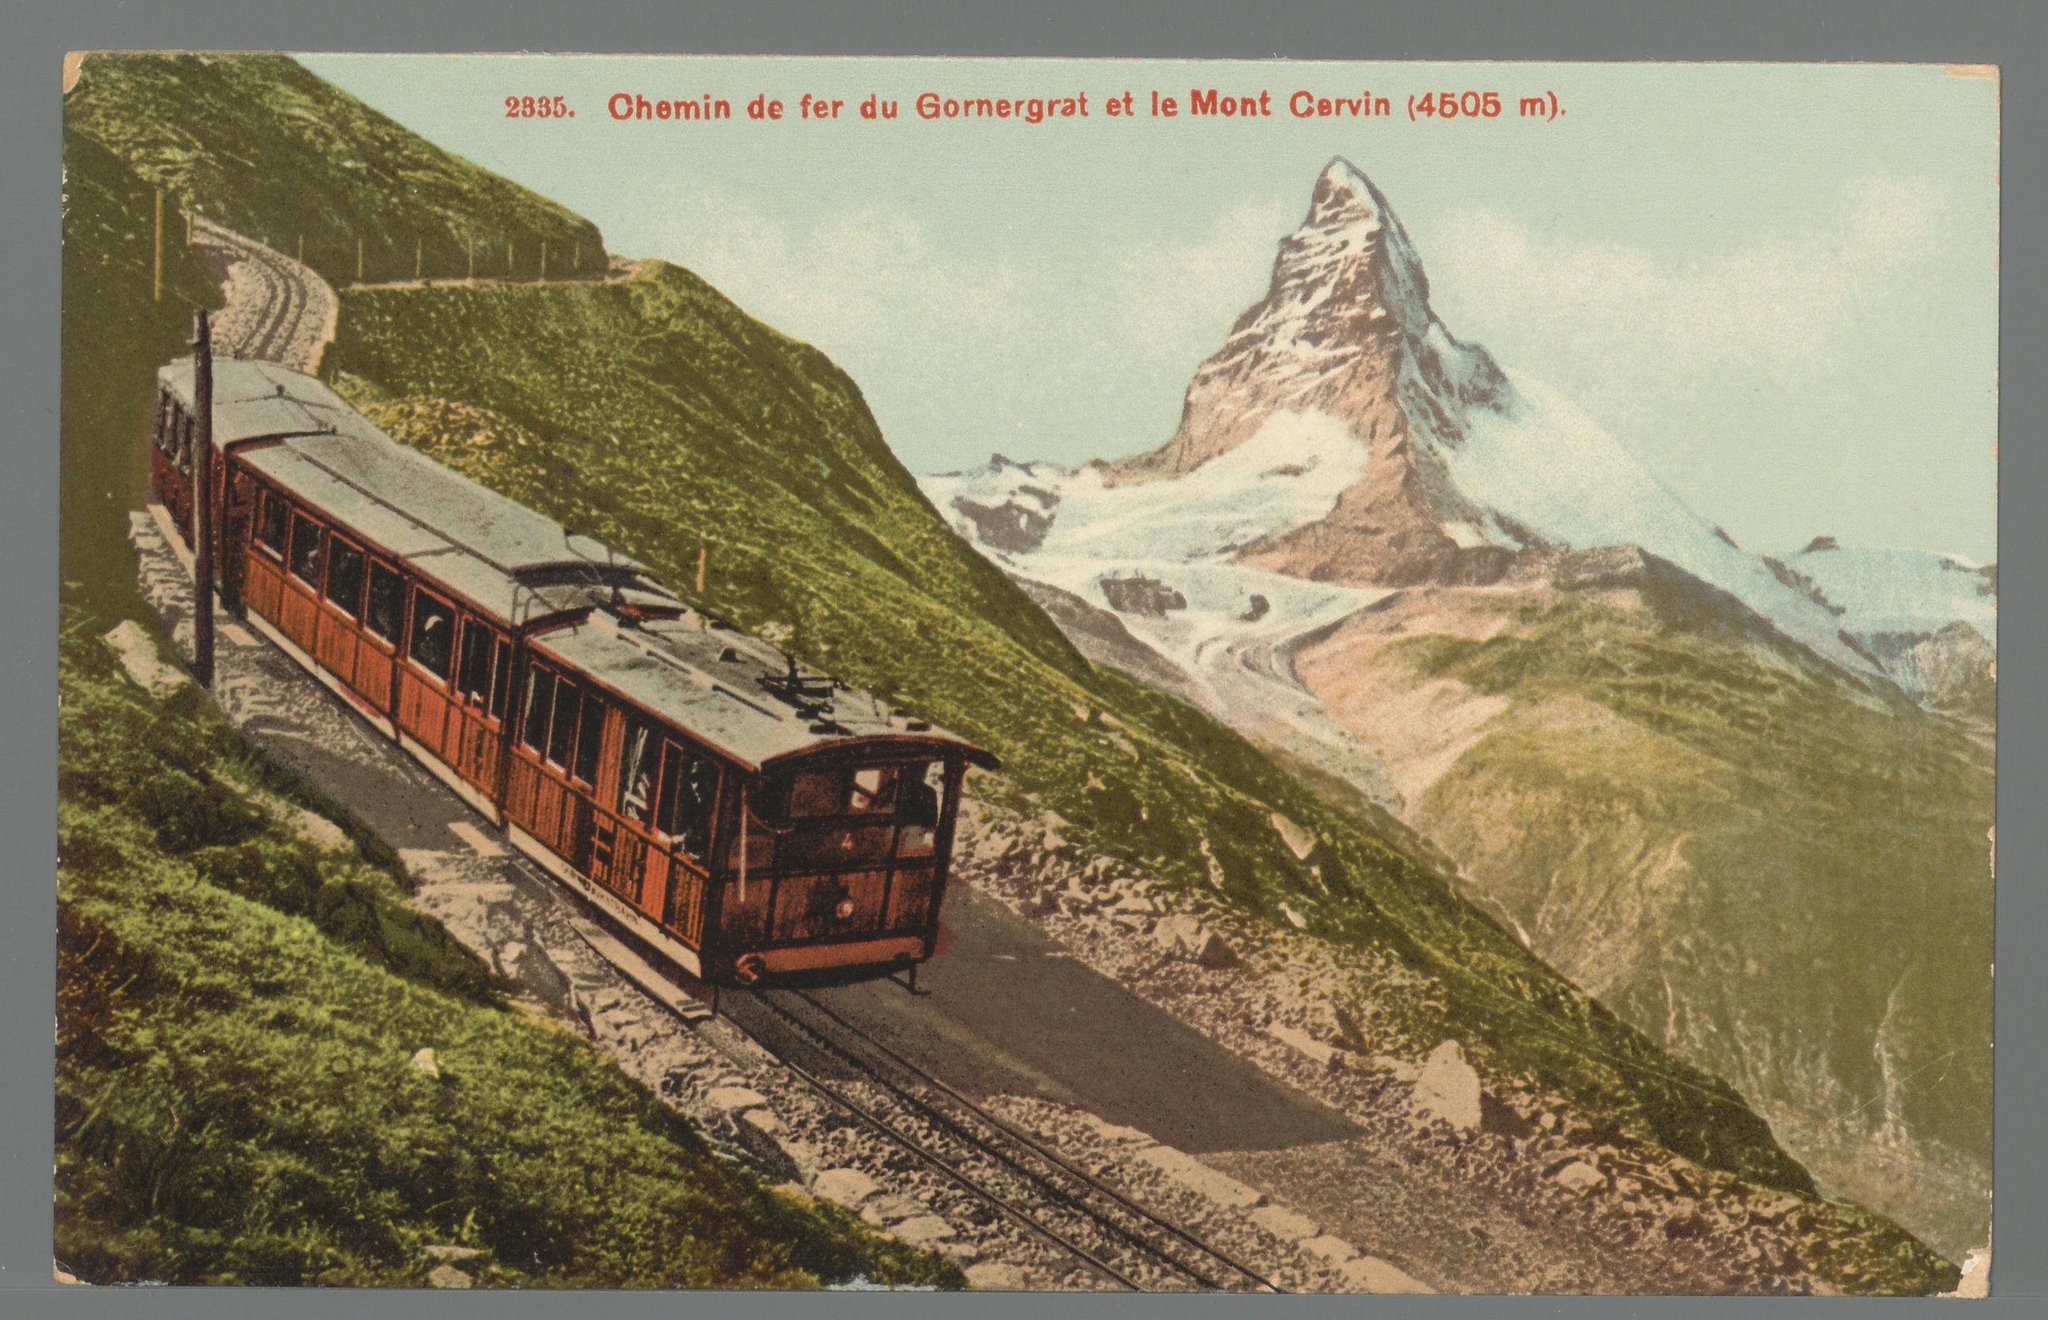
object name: ansichtkaart, prentbriefkaart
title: Chemin de fer du Gornergrat et le Mont Cervin (4505 m)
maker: Anonymous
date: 1903-1906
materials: cardboard, photographic process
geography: zurich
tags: passenger train, mountain-range, snow peaks